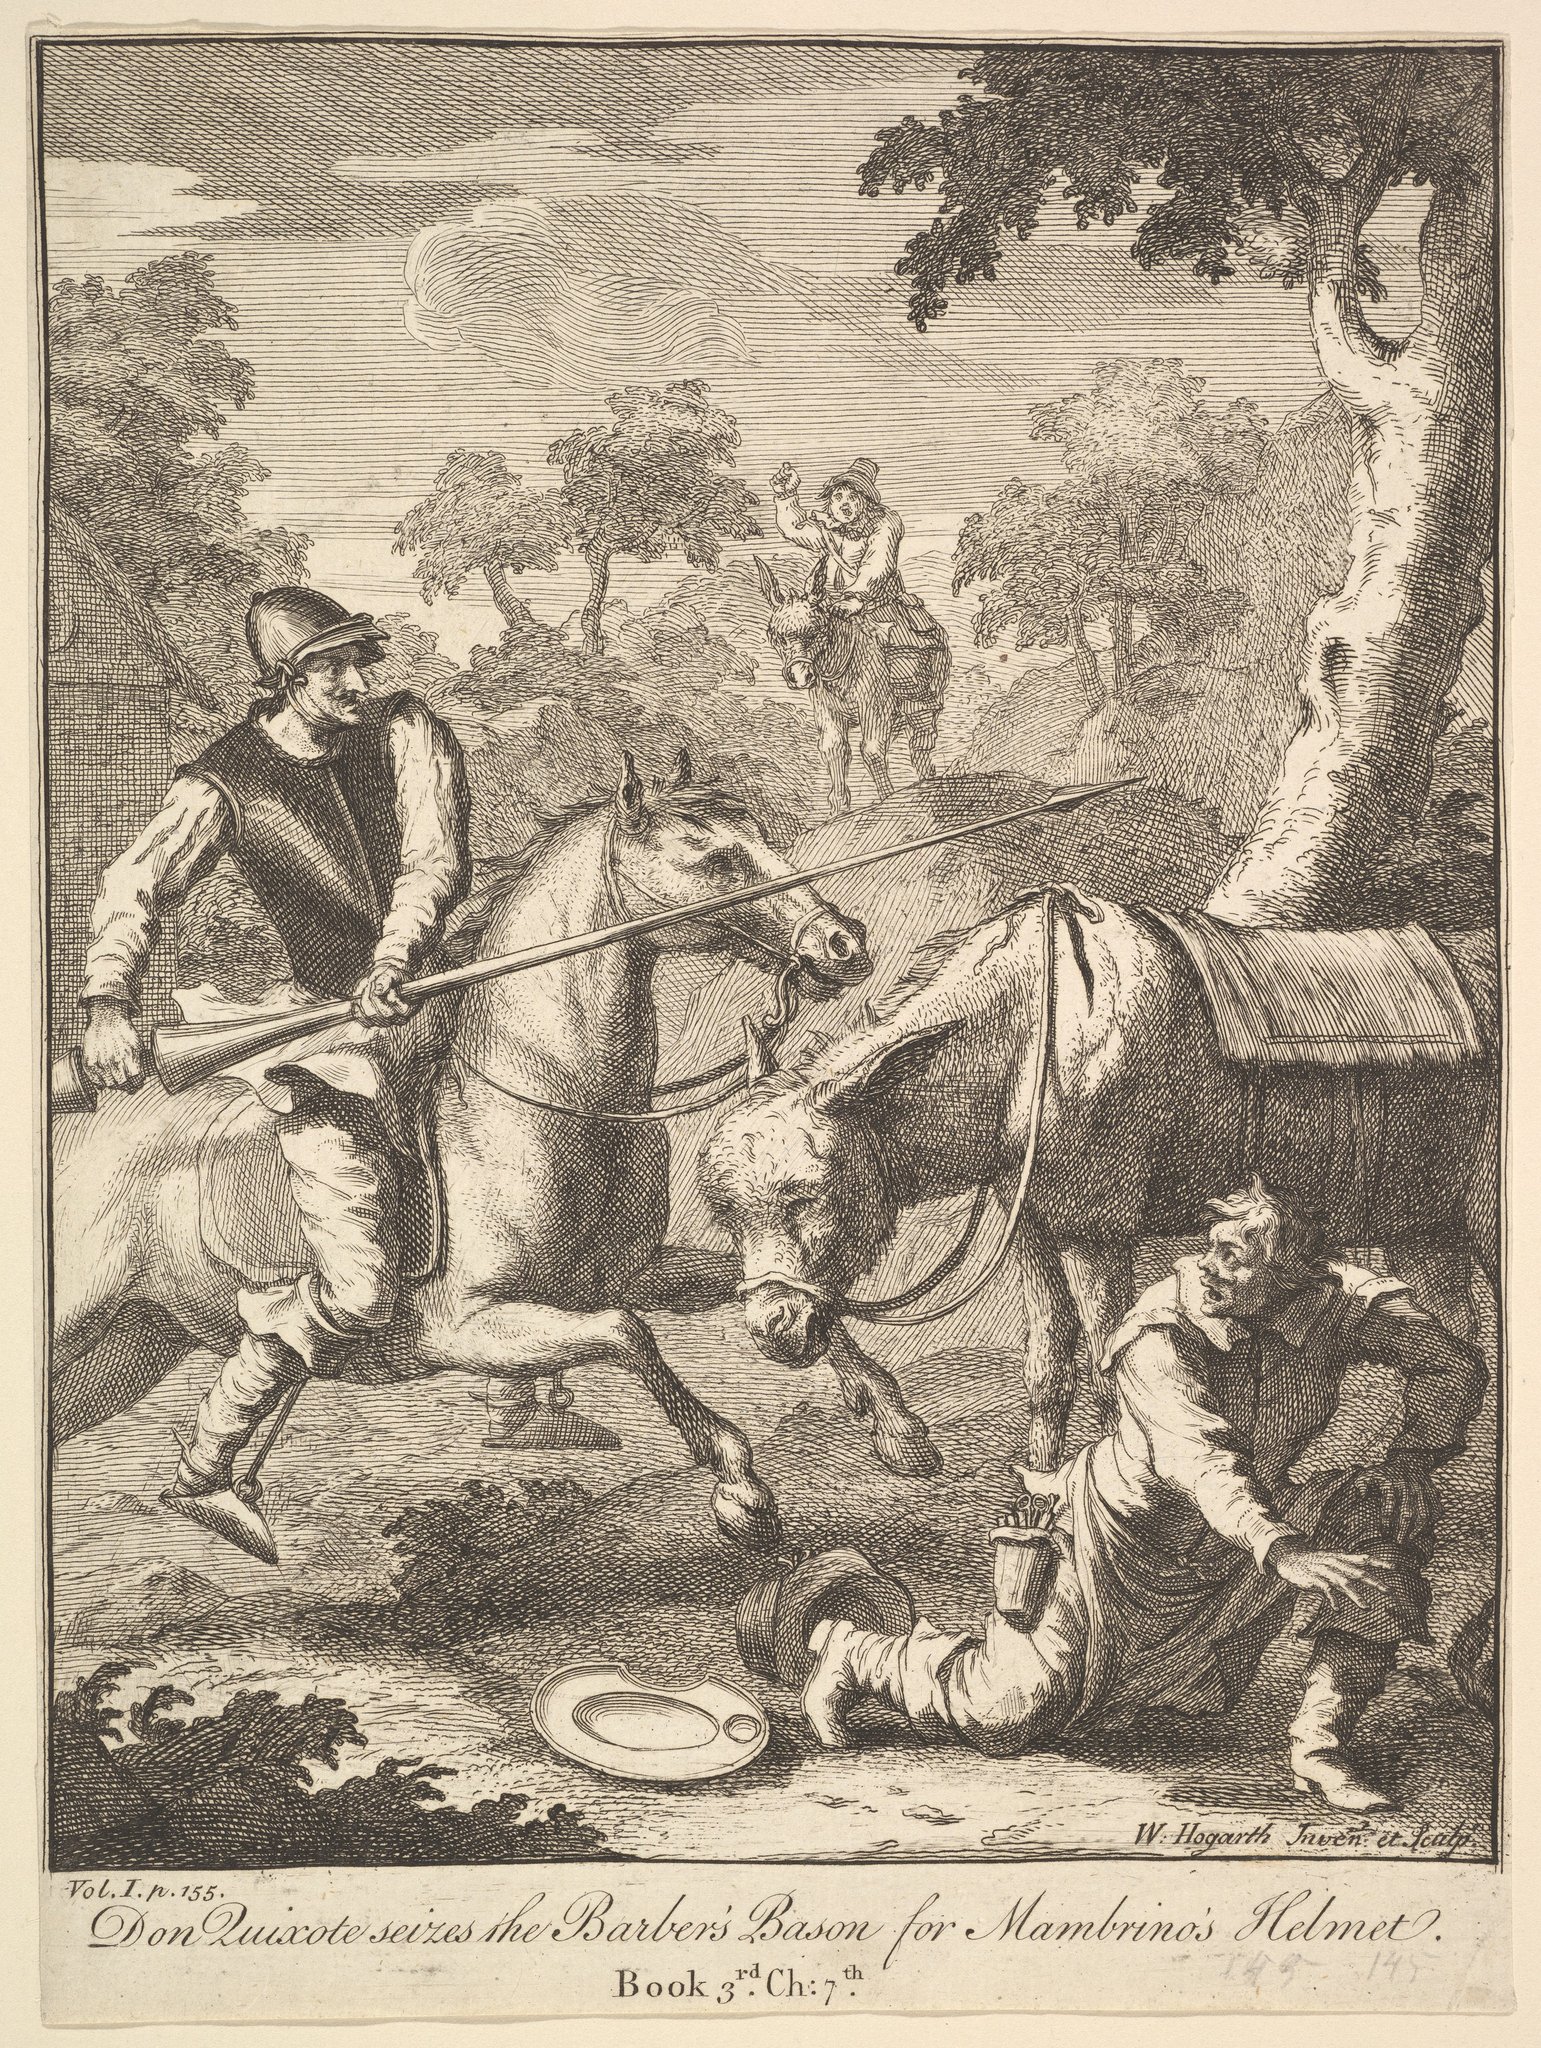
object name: print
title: The Adventure of Mambrino's Helmet (Six Illustrations for Don Quixote)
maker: william hogarth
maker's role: artist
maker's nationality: british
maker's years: 1697-1764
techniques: engraving, etching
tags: spears,horses,don quixote